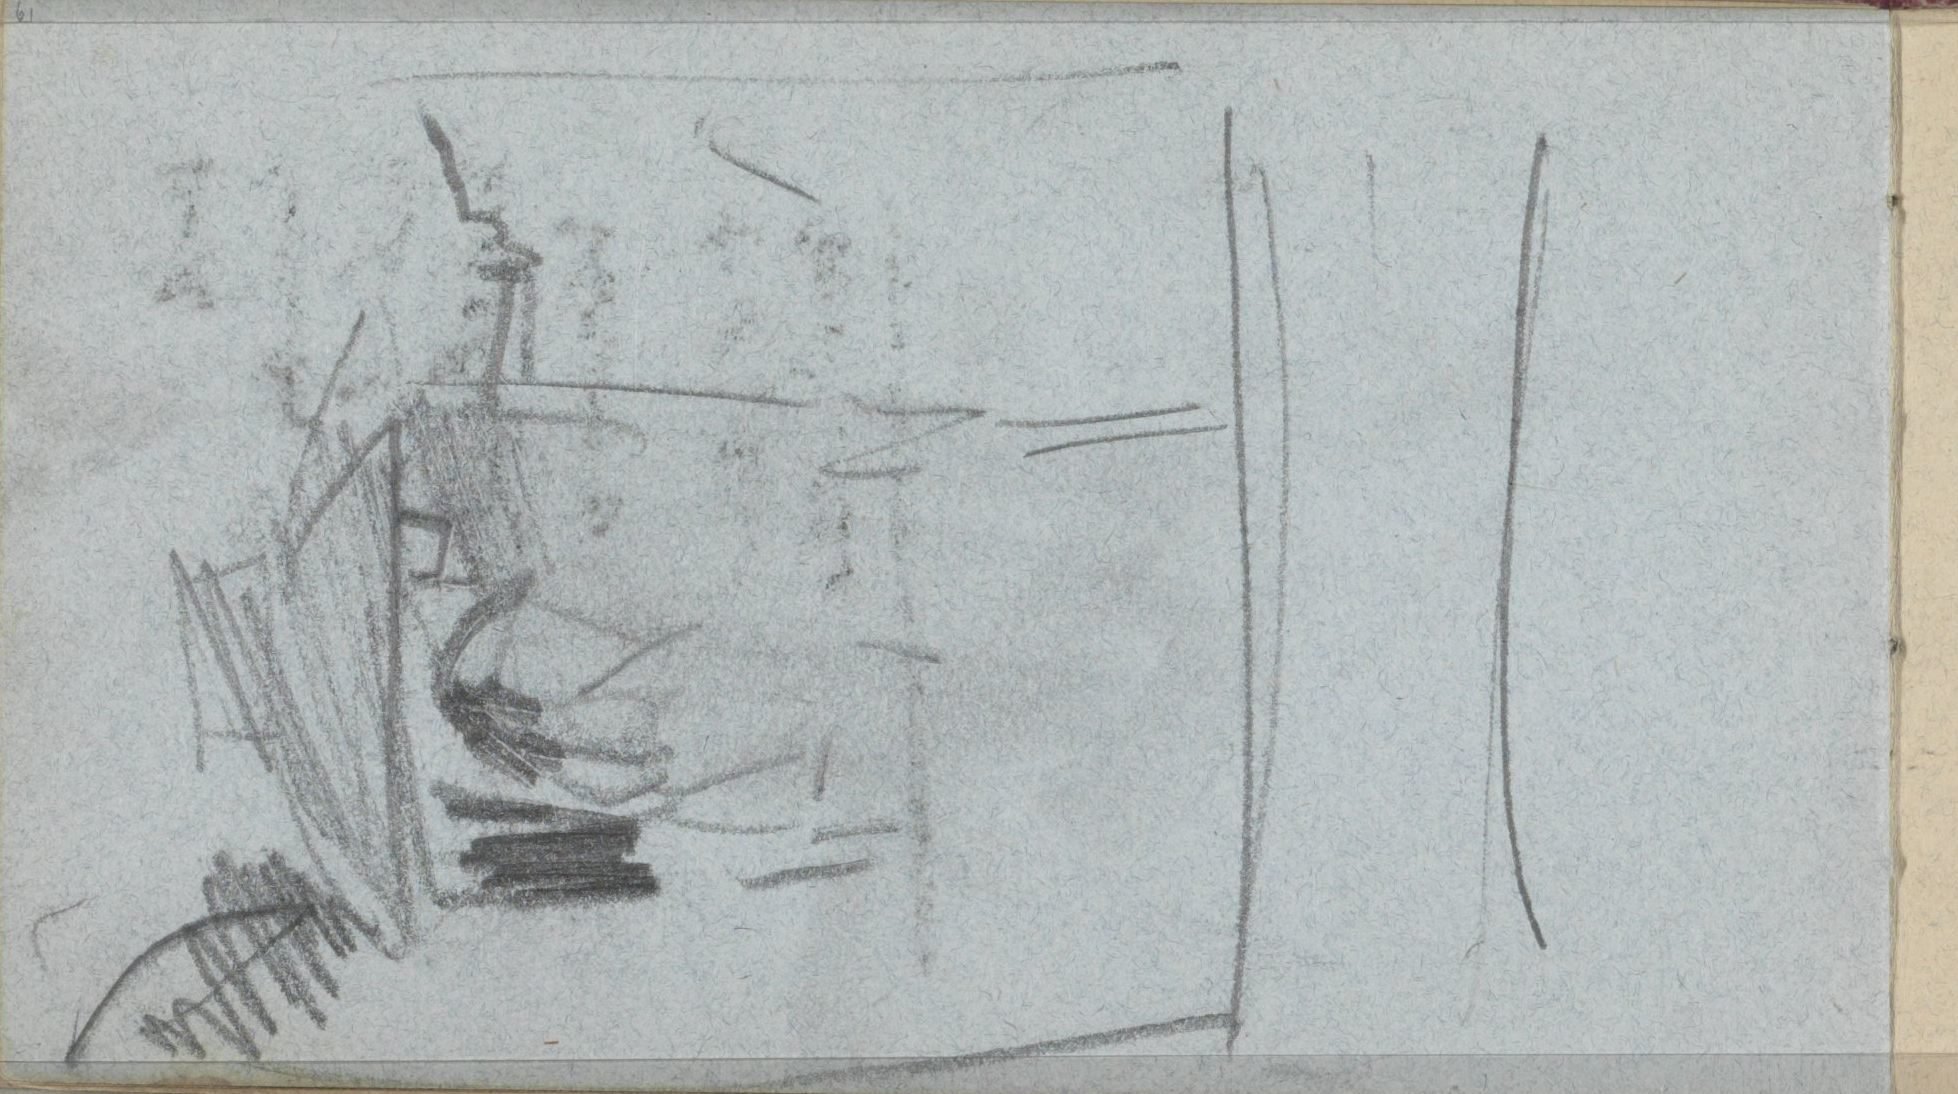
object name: sketchbook leaf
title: Figuur, mogelijk voor een klein gebouw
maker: george hendrik breitner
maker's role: draughtsman, painter, print maker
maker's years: 1857-1923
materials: paper, pencil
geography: amsterdam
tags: adult woman, architecture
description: Pagina 61 uit een schetsboek met 32 bladen.